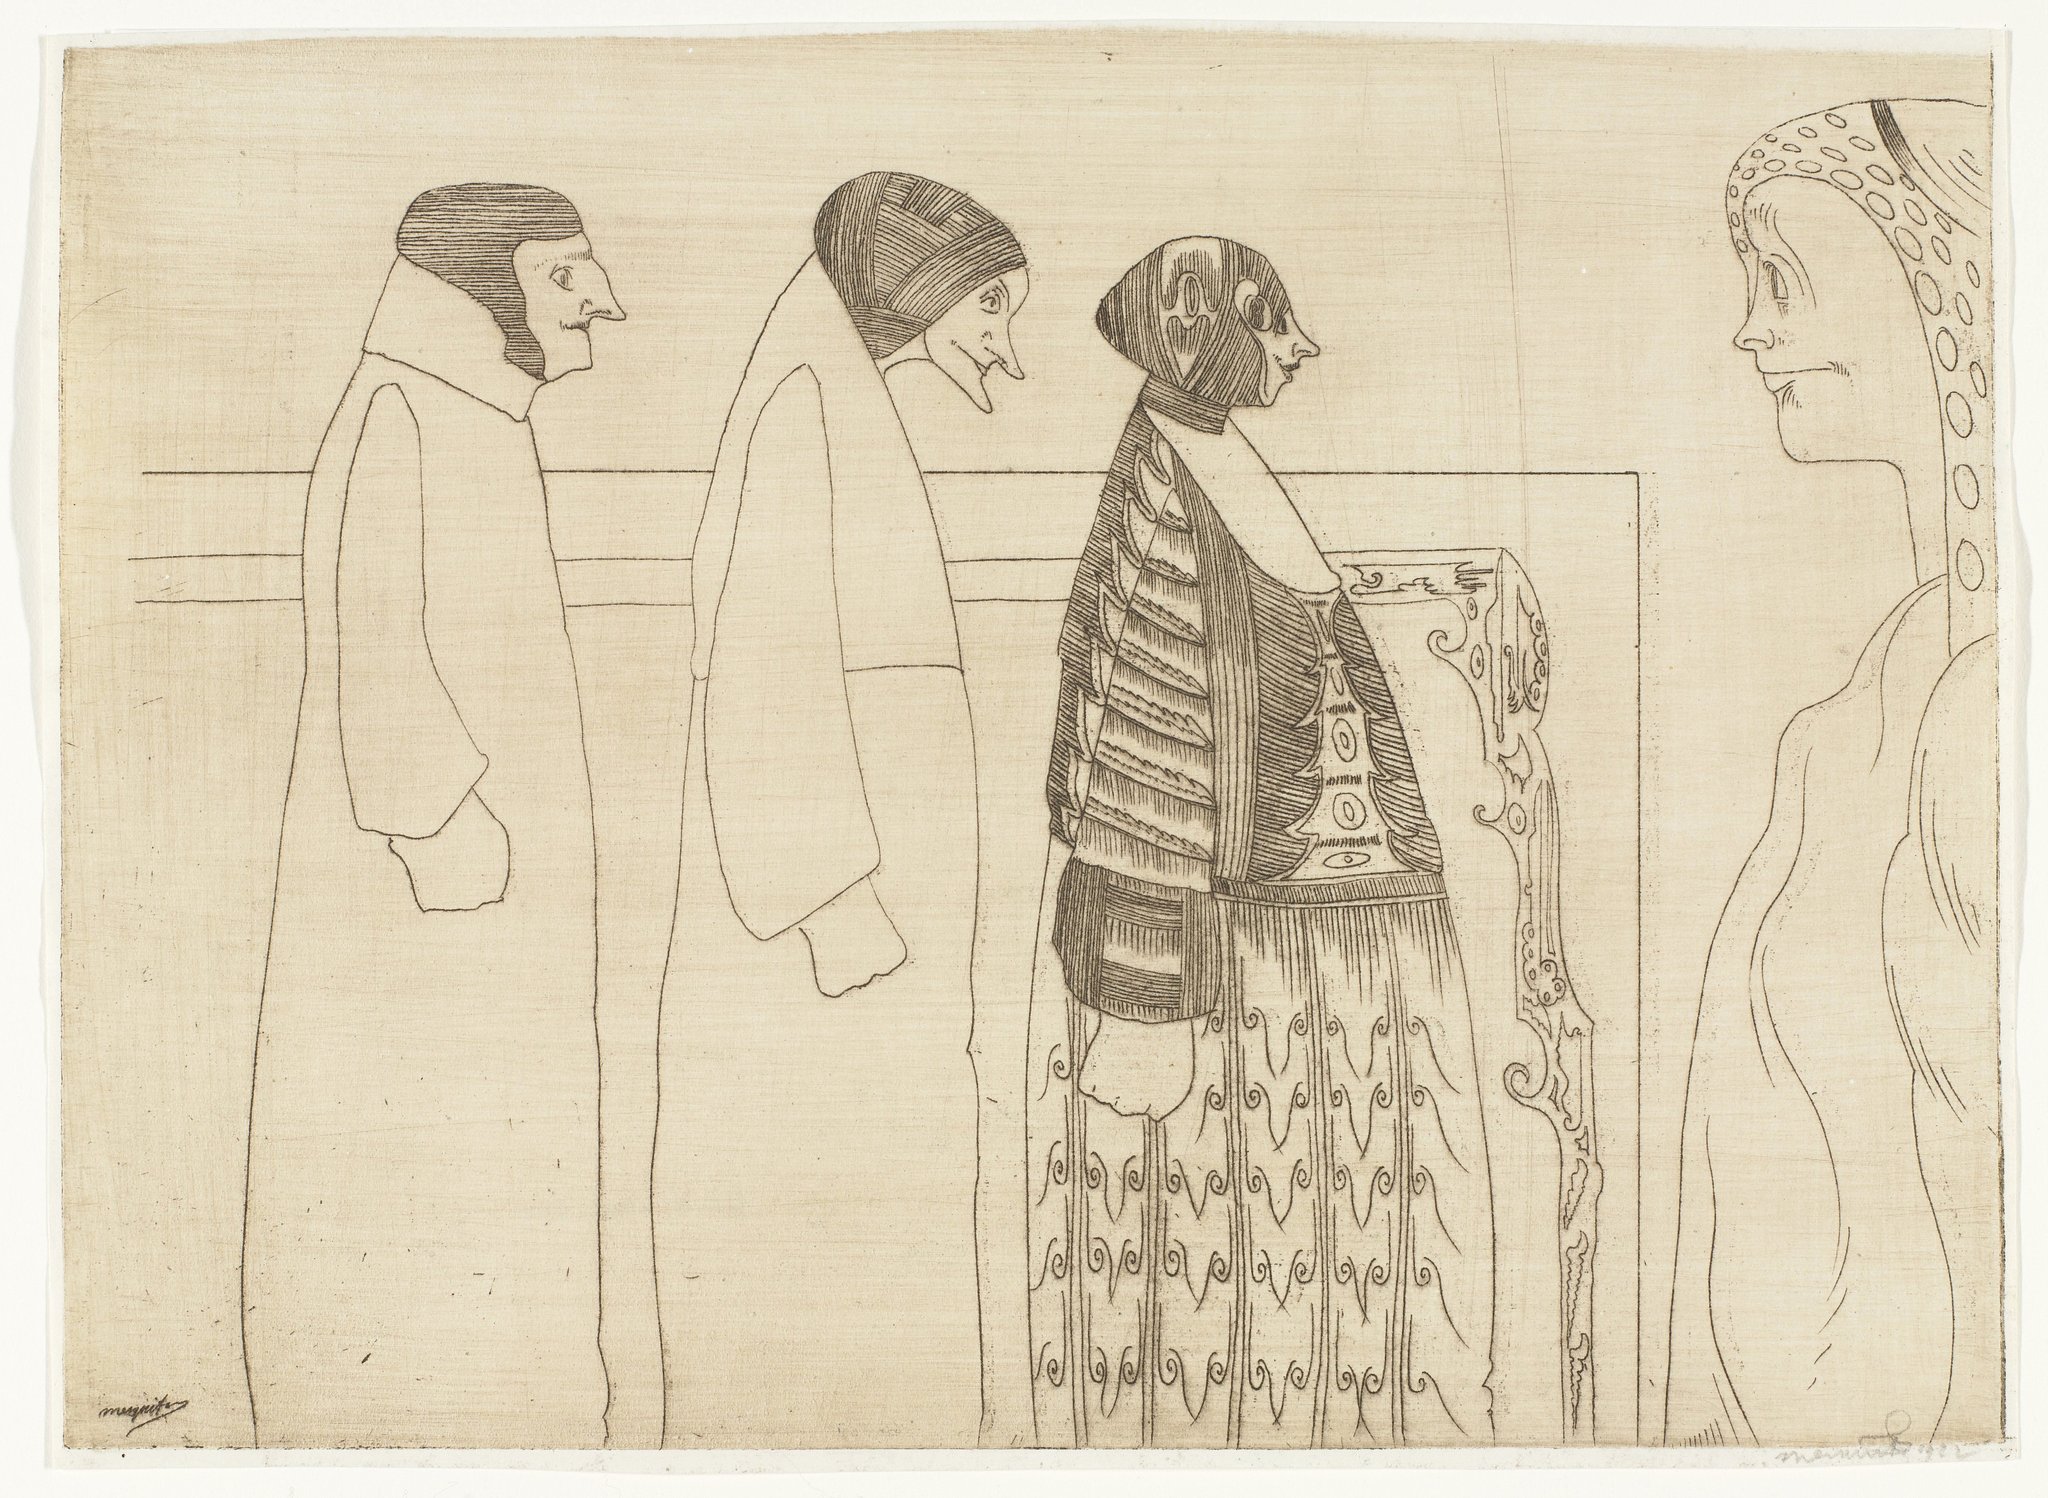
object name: print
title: Drie figuren naar rechts en één naar links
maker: samuel jessurun de mesquita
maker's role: draughtsman, print maker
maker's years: 1868-1944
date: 1922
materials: paper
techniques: drypoint, etching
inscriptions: signature and date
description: Vier staande of lopende figuren, en profil, drie naar rechts en de meest rechtse naar links gewend. Van één figuur zijn de patronen op de kleding uitgewerkt. Op de achtergrond een omlijsting.